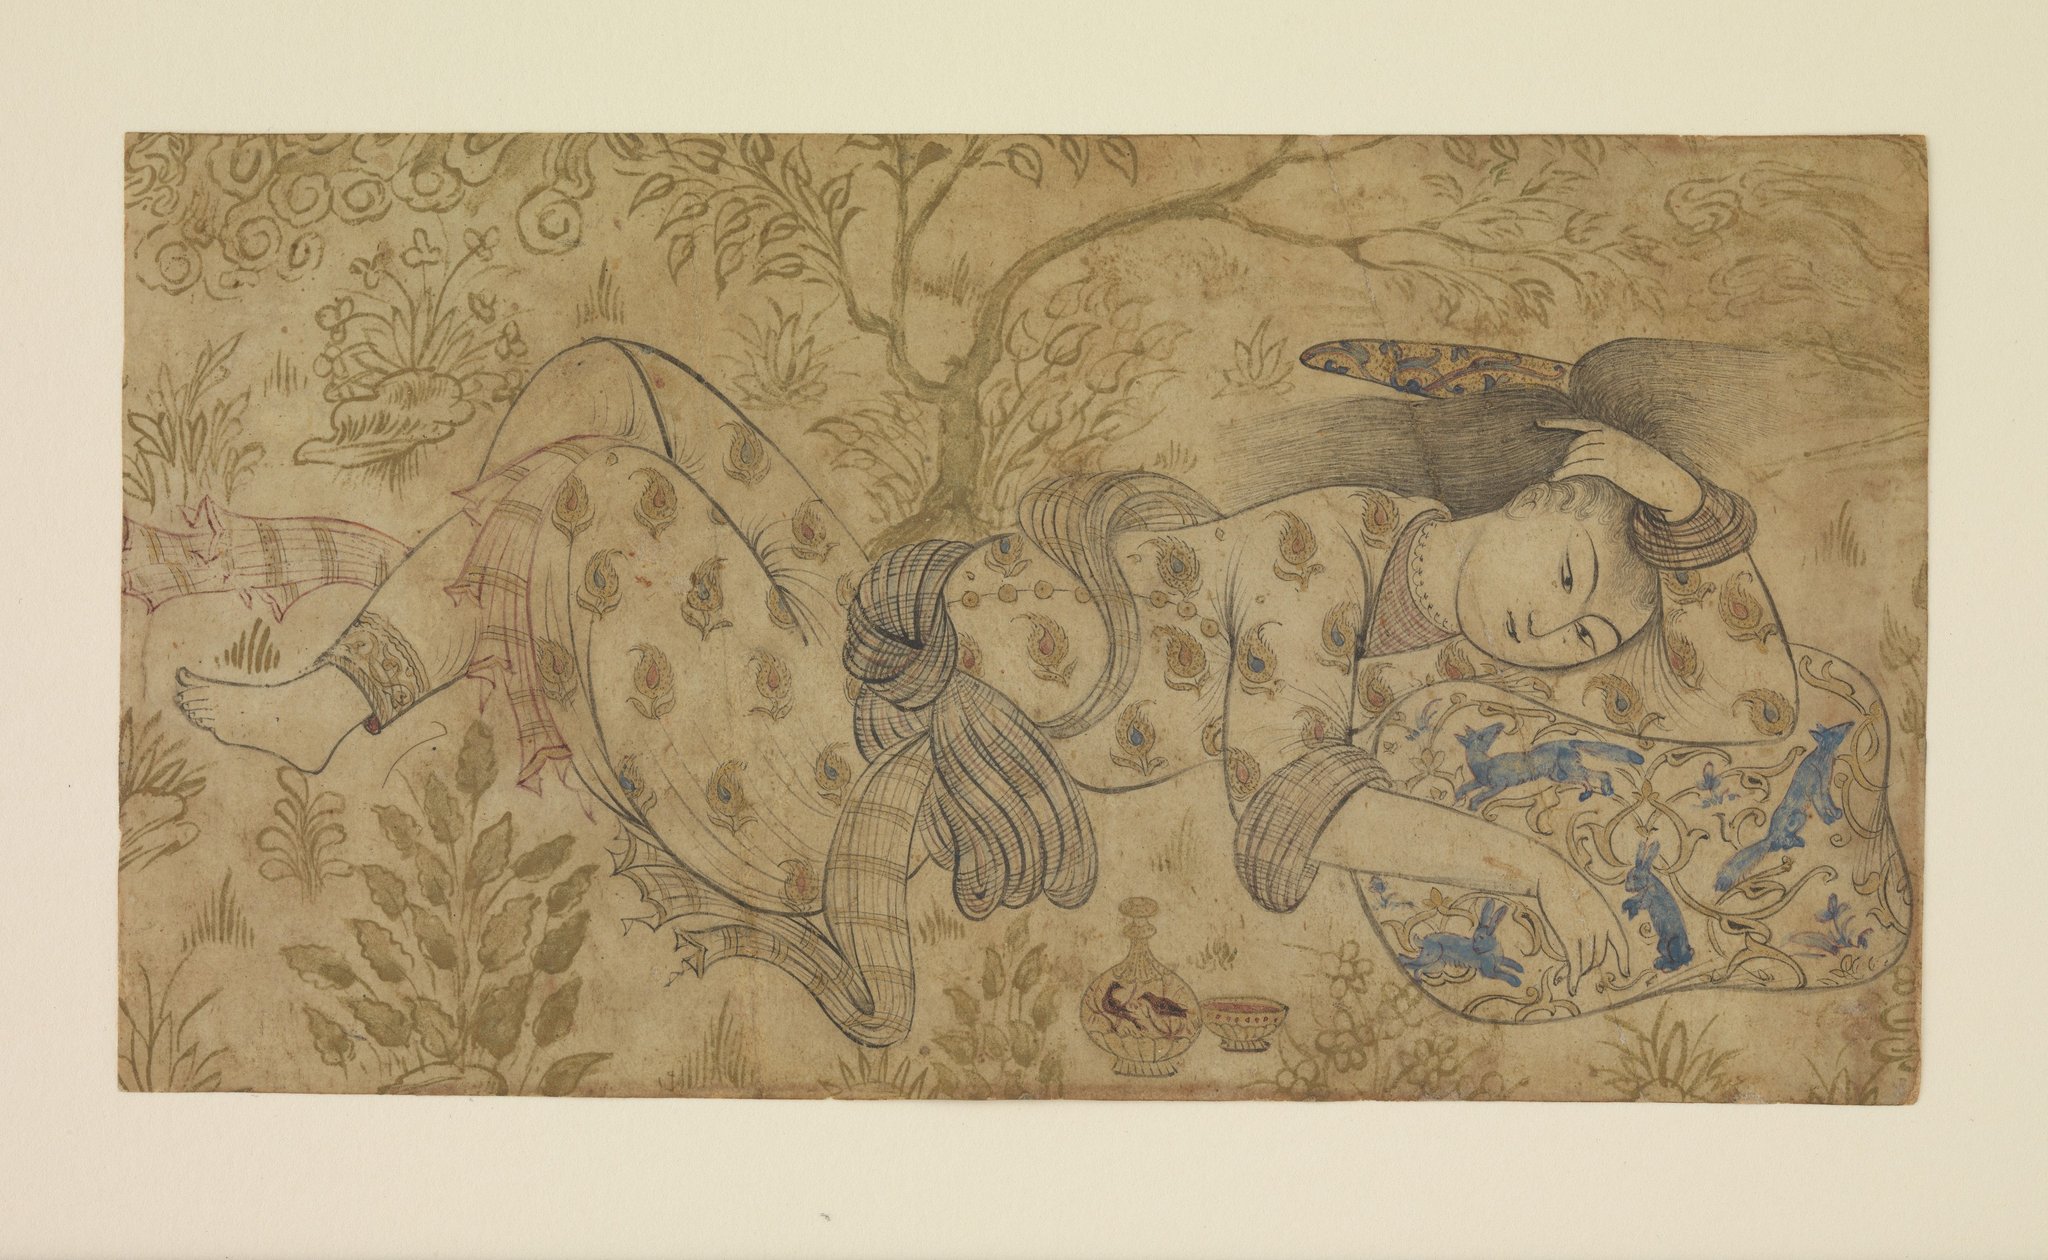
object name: illustrated single work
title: Reclining Figure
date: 1630-1640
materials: gold, ink, paper, watercolor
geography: iran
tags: human figures